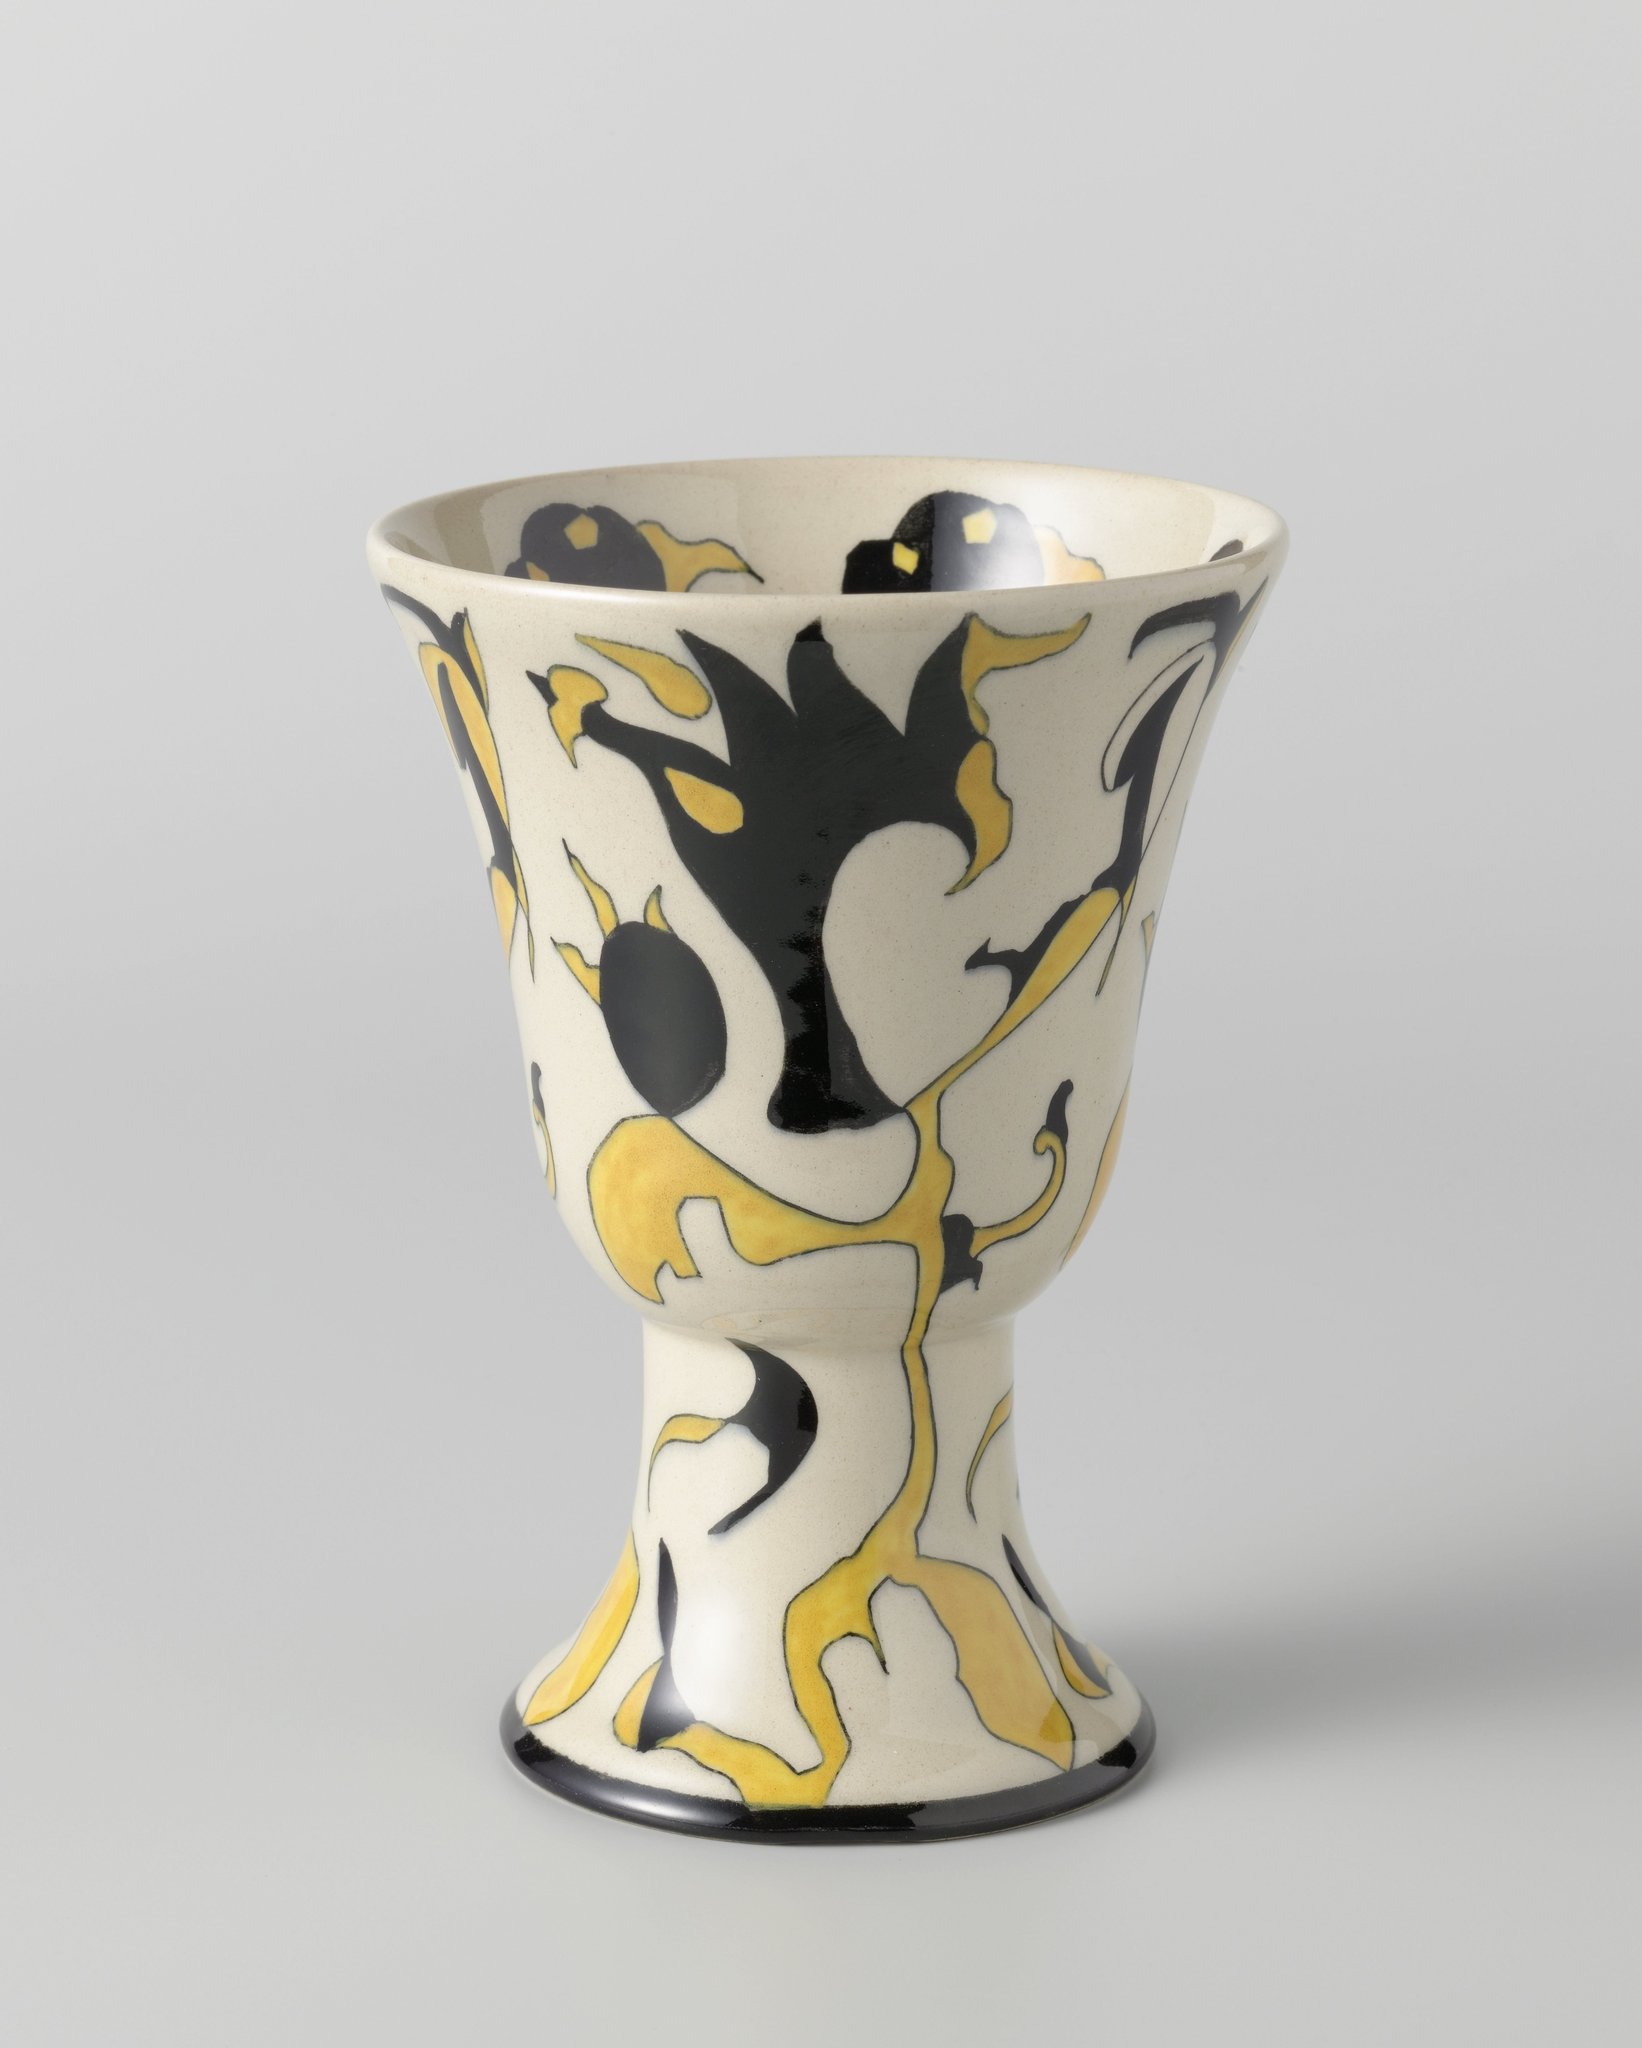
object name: vase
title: Two beakers with the ‘Hol’ (Hollow) pattern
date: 1923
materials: earthenware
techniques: painted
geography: arnhem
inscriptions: mark: ‘fabrieksstempel in cirkelvorm, 124/AP/"Hol" (in zwart)’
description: Vaas, bekervormig, met decor "Hol" in zwart en geel. Gemerkt met fabrieksstempel in cirkelvorm, 124/AP/"Hol" (in zwart)